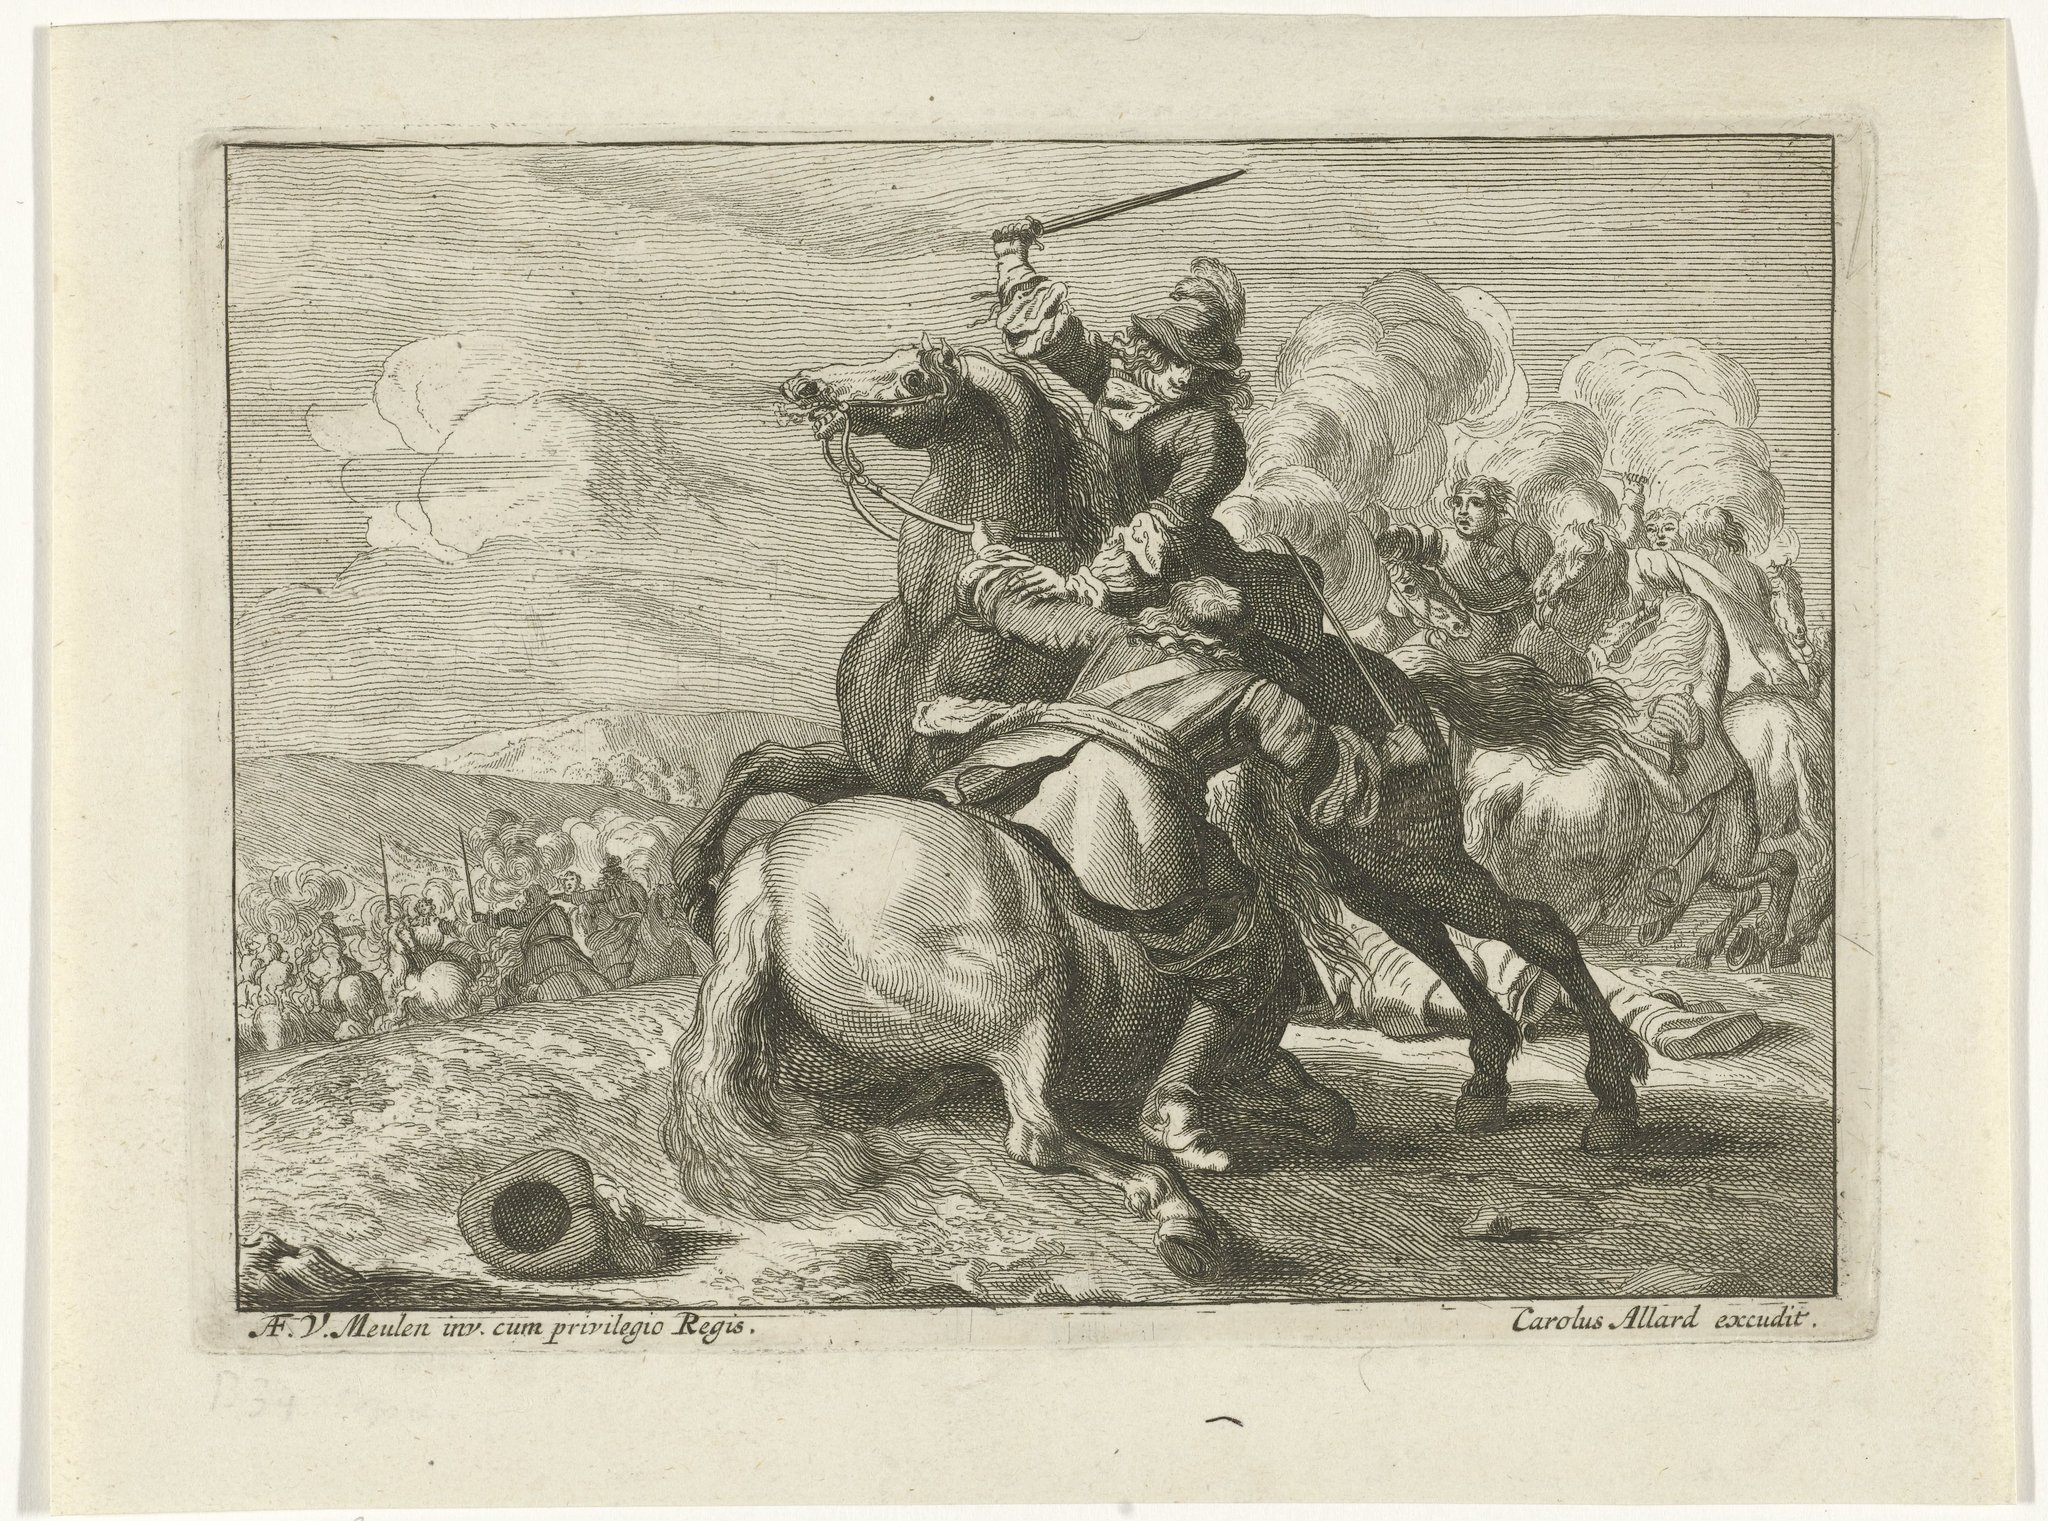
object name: print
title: Zwaardgevecht tussen twee ruiters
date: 1673-1709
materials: paper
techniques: engraving, etching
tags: war and peace (+ cavalry, horsemen)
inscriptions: collector's mark: Lugt 2228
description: Een soldaat op een steigerend paard valt met zijn zwaard een soldaat aan, wiens paard door de hoeven is gezakt. De hoed van de laatste soldaat is afgevallen en ligt linksvoor op de grond. Vechtende cavalerie op de achtergrond.